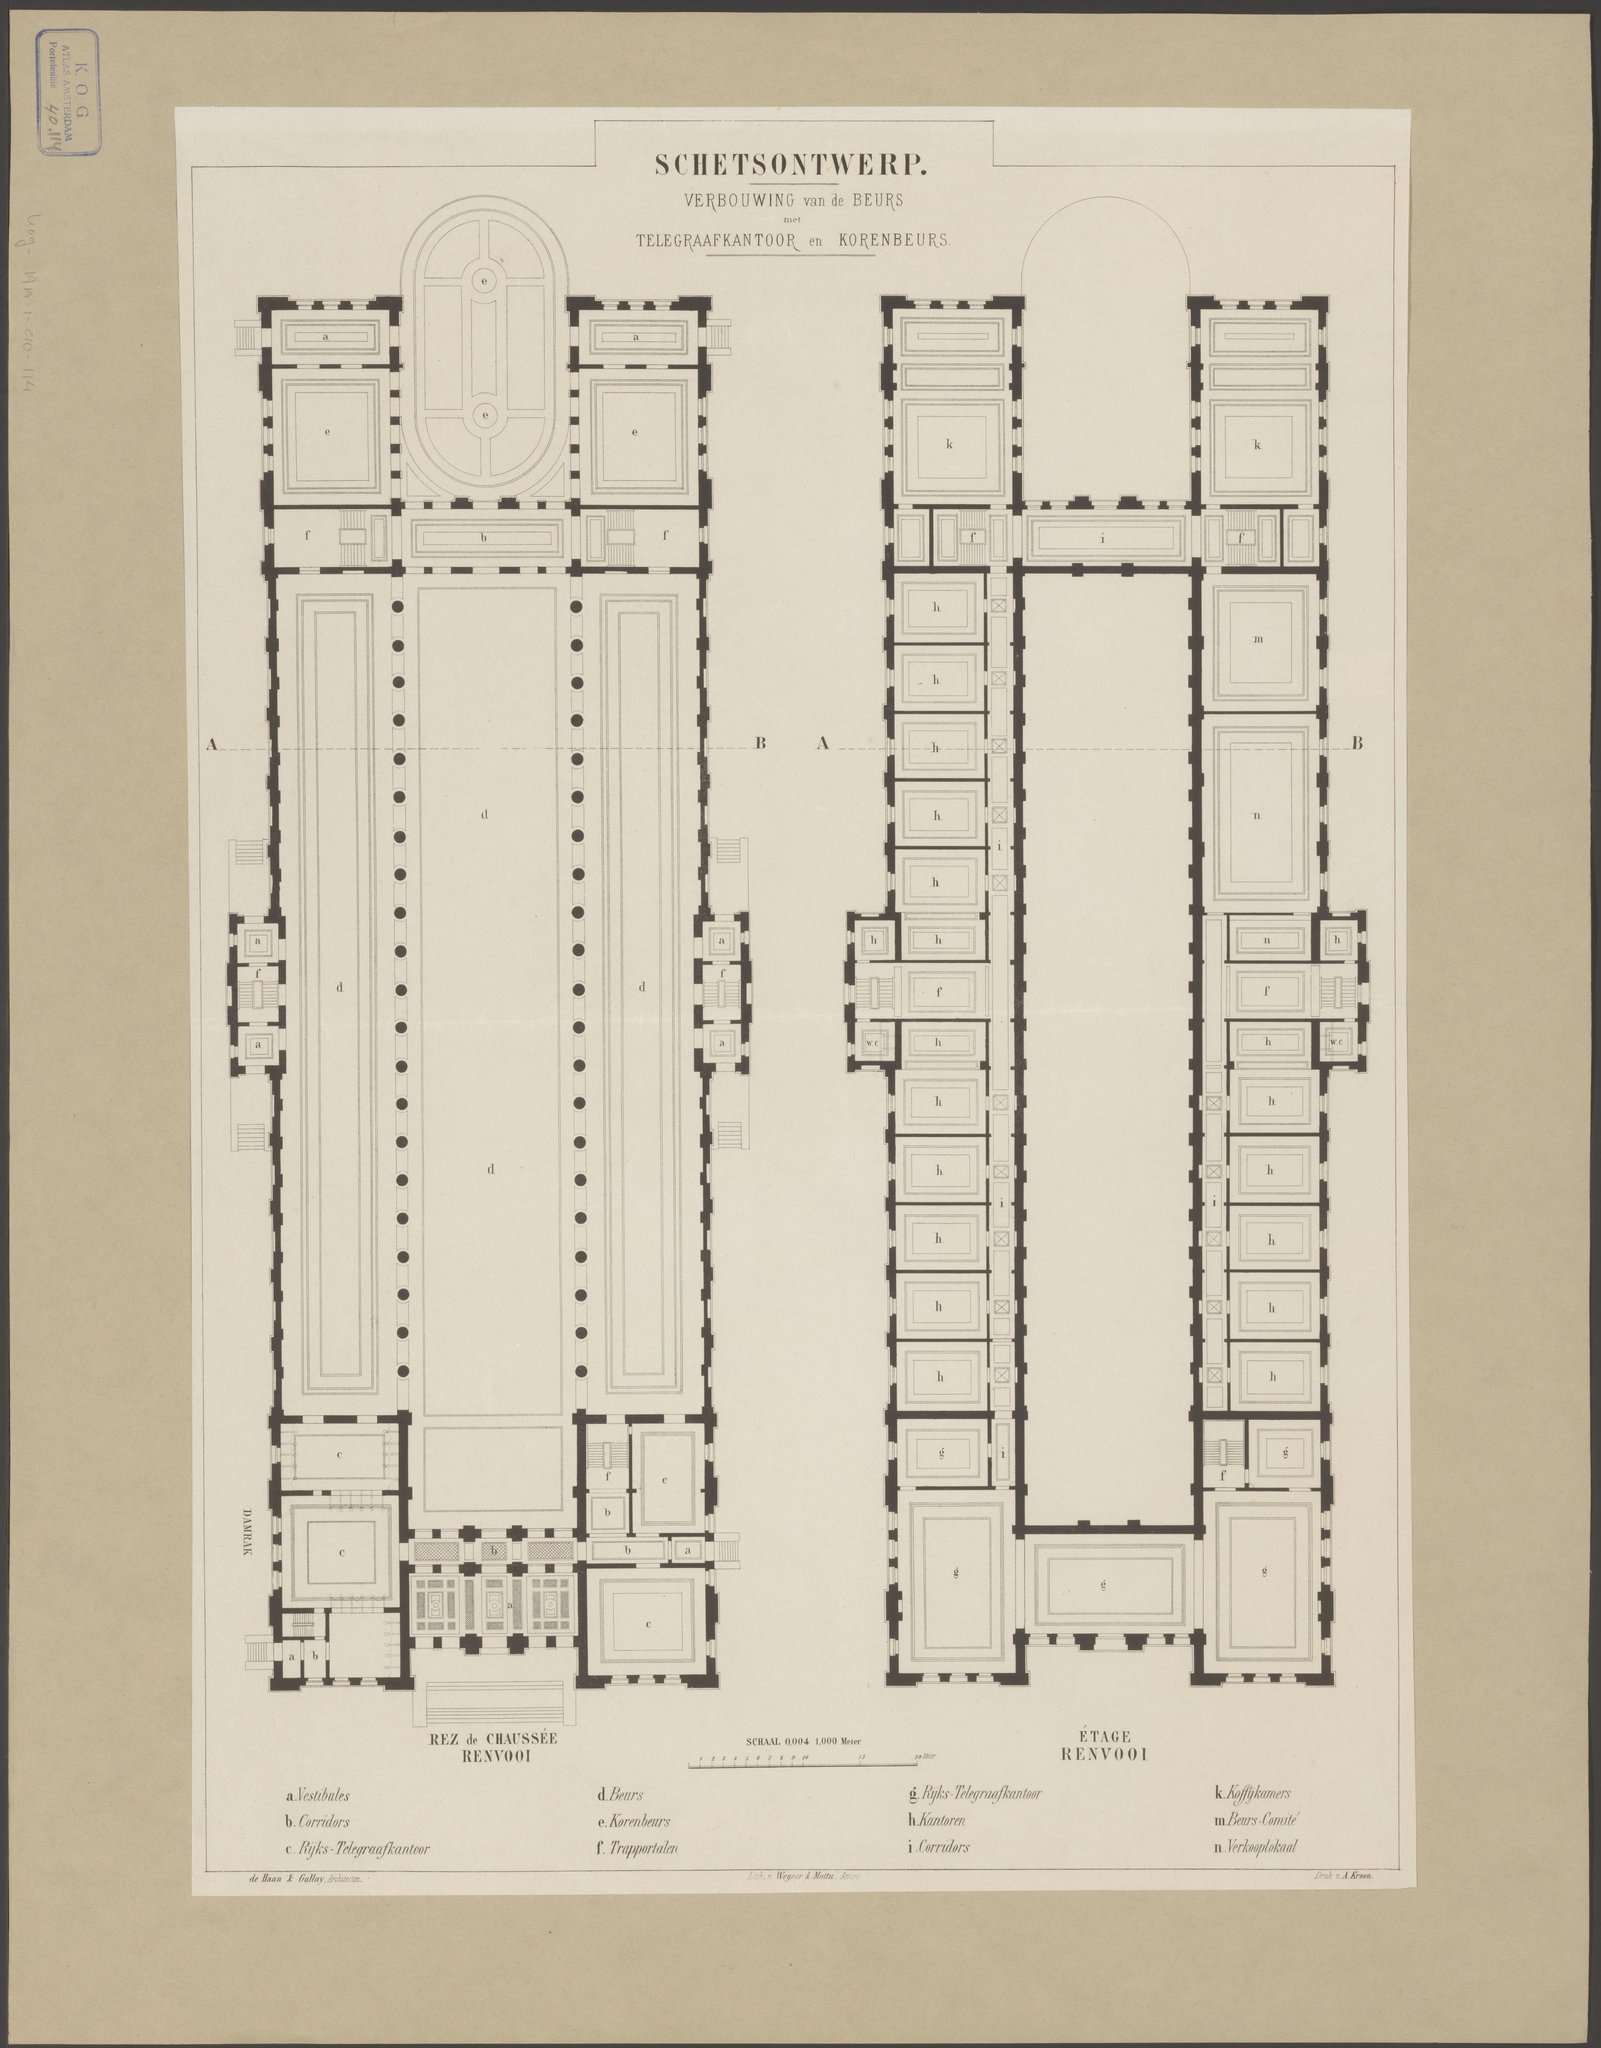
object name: print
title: Ontwerp en plattegronden van twee verdiepingen voor de Nieuwe Beurs te Amsterdam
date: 1870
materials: paper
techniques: lithograph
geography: amsterdam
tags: stock exchange, stock-market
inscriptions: collector's mark: Lugt 1641b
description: Prent genoemd en gedateerd in: Catalogus van de bibliotheek der stad Amsterdam. Amsterdam: Stadsdrukkerij, 1876, dl. 6, p. 539.